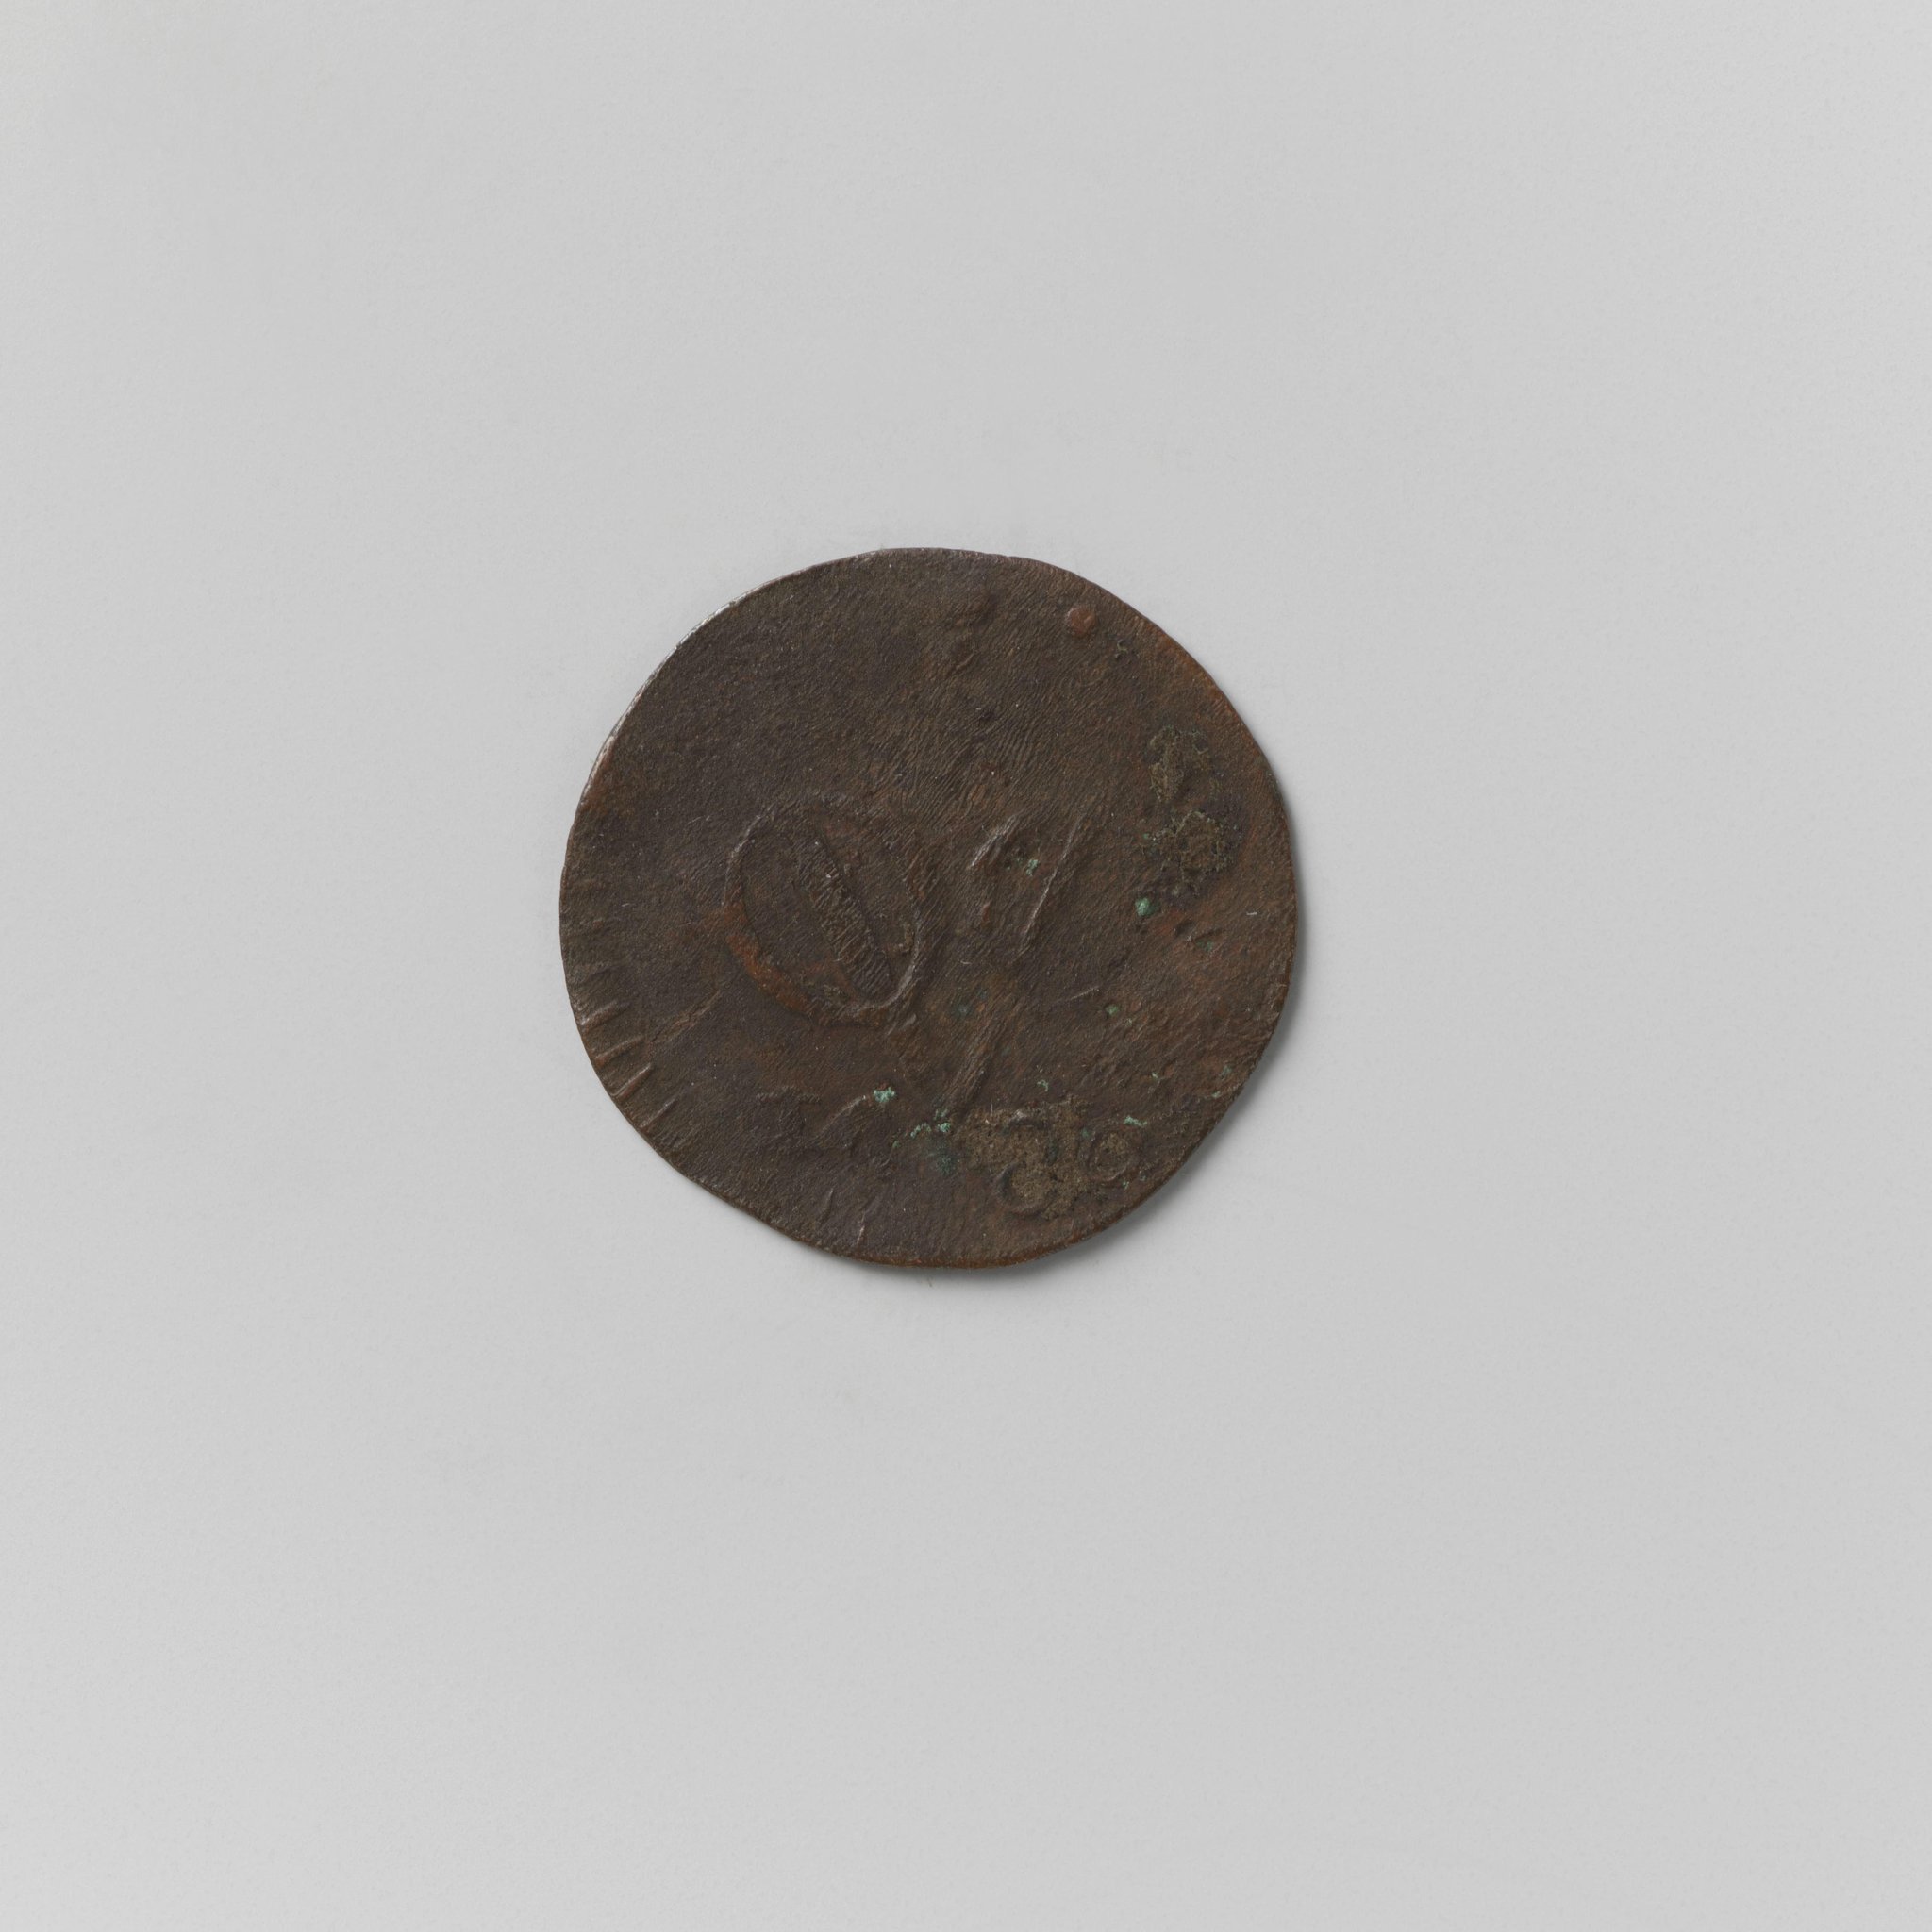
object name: coin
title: Valse ½ duit van de VOC uit Holland, 1780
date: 1780-1799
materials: copper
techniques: striking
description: Valse koperen munt. Voorzijde: tussen wapenspreuk gekroond wapenschild van Holland. Keerzijde: monogram van de VOC, waarboven muntteken en waaronder jaartal. Vervalsing. Jaartal bestaat niet.